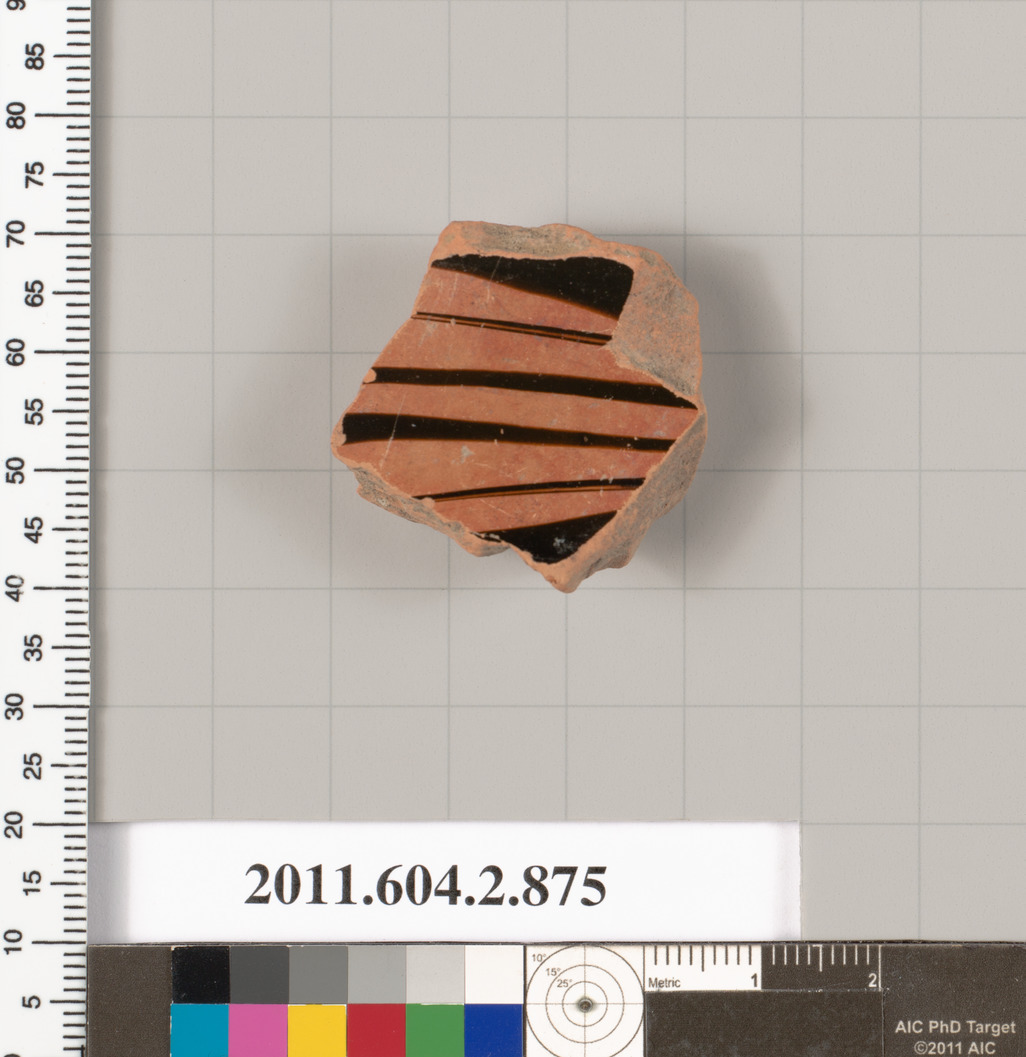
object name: bell krater fragment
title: Terracotta fragment of a bell-krater (bowl for mixing wine and water)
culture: greek, attic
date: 450-426 BCE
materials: terracotta